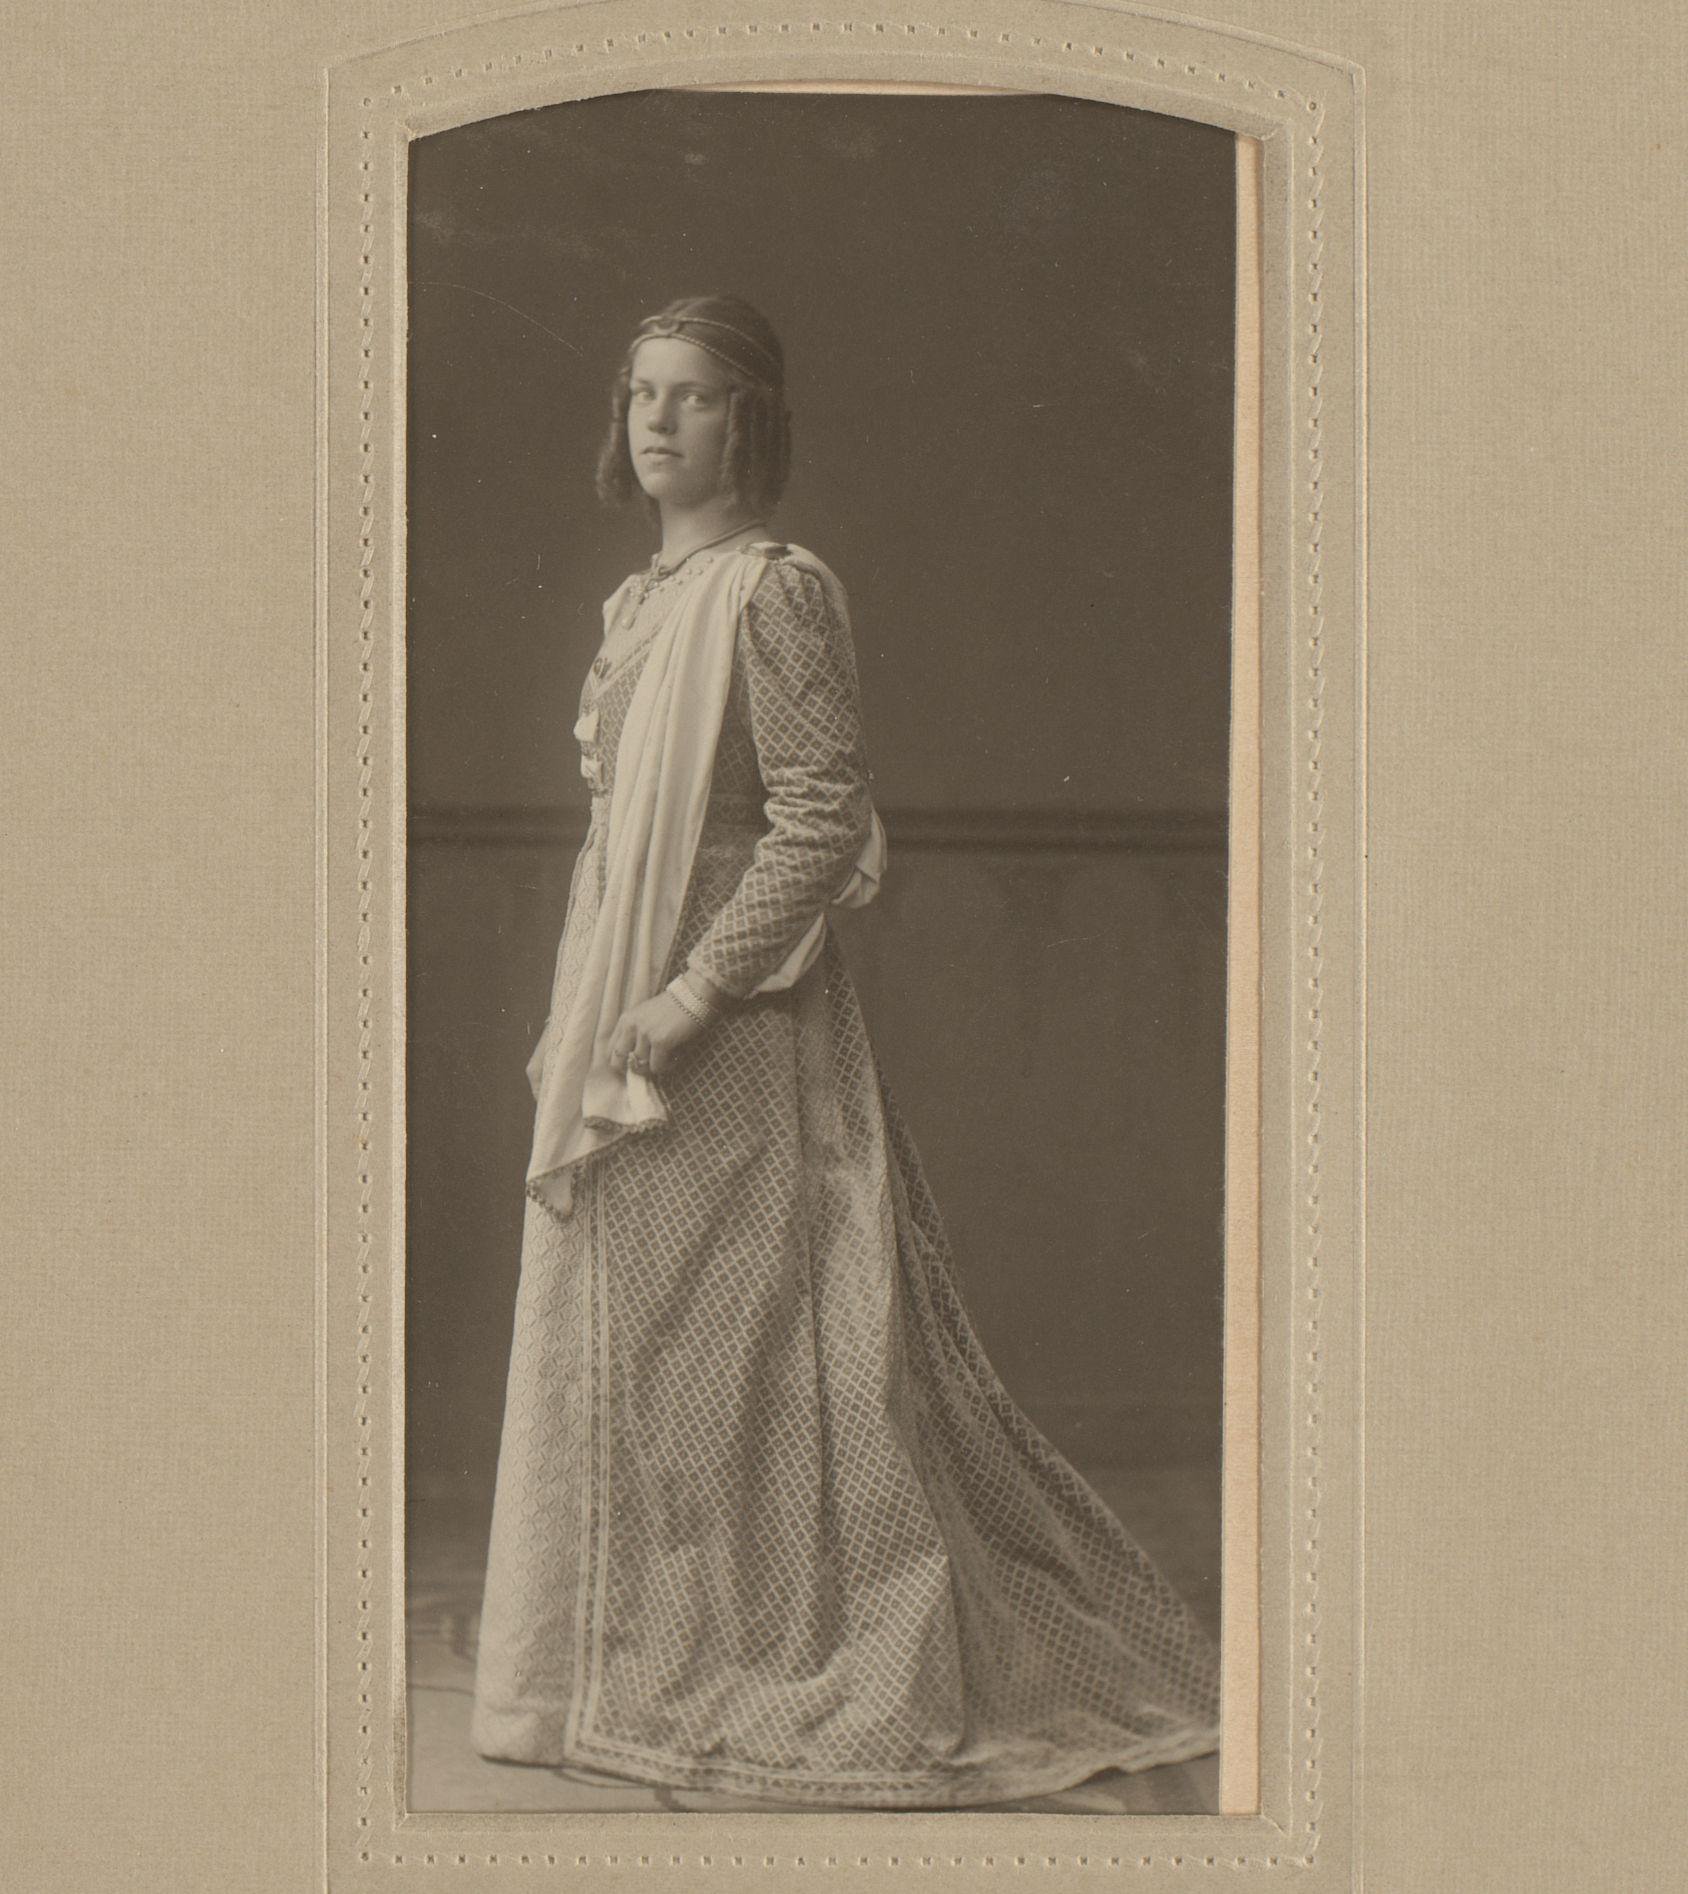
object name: photograph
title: Studioportret van een meisje in historisch kostuum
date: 1900-1920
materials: paper, photographic support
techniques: gelatin silver print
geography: dordrecht